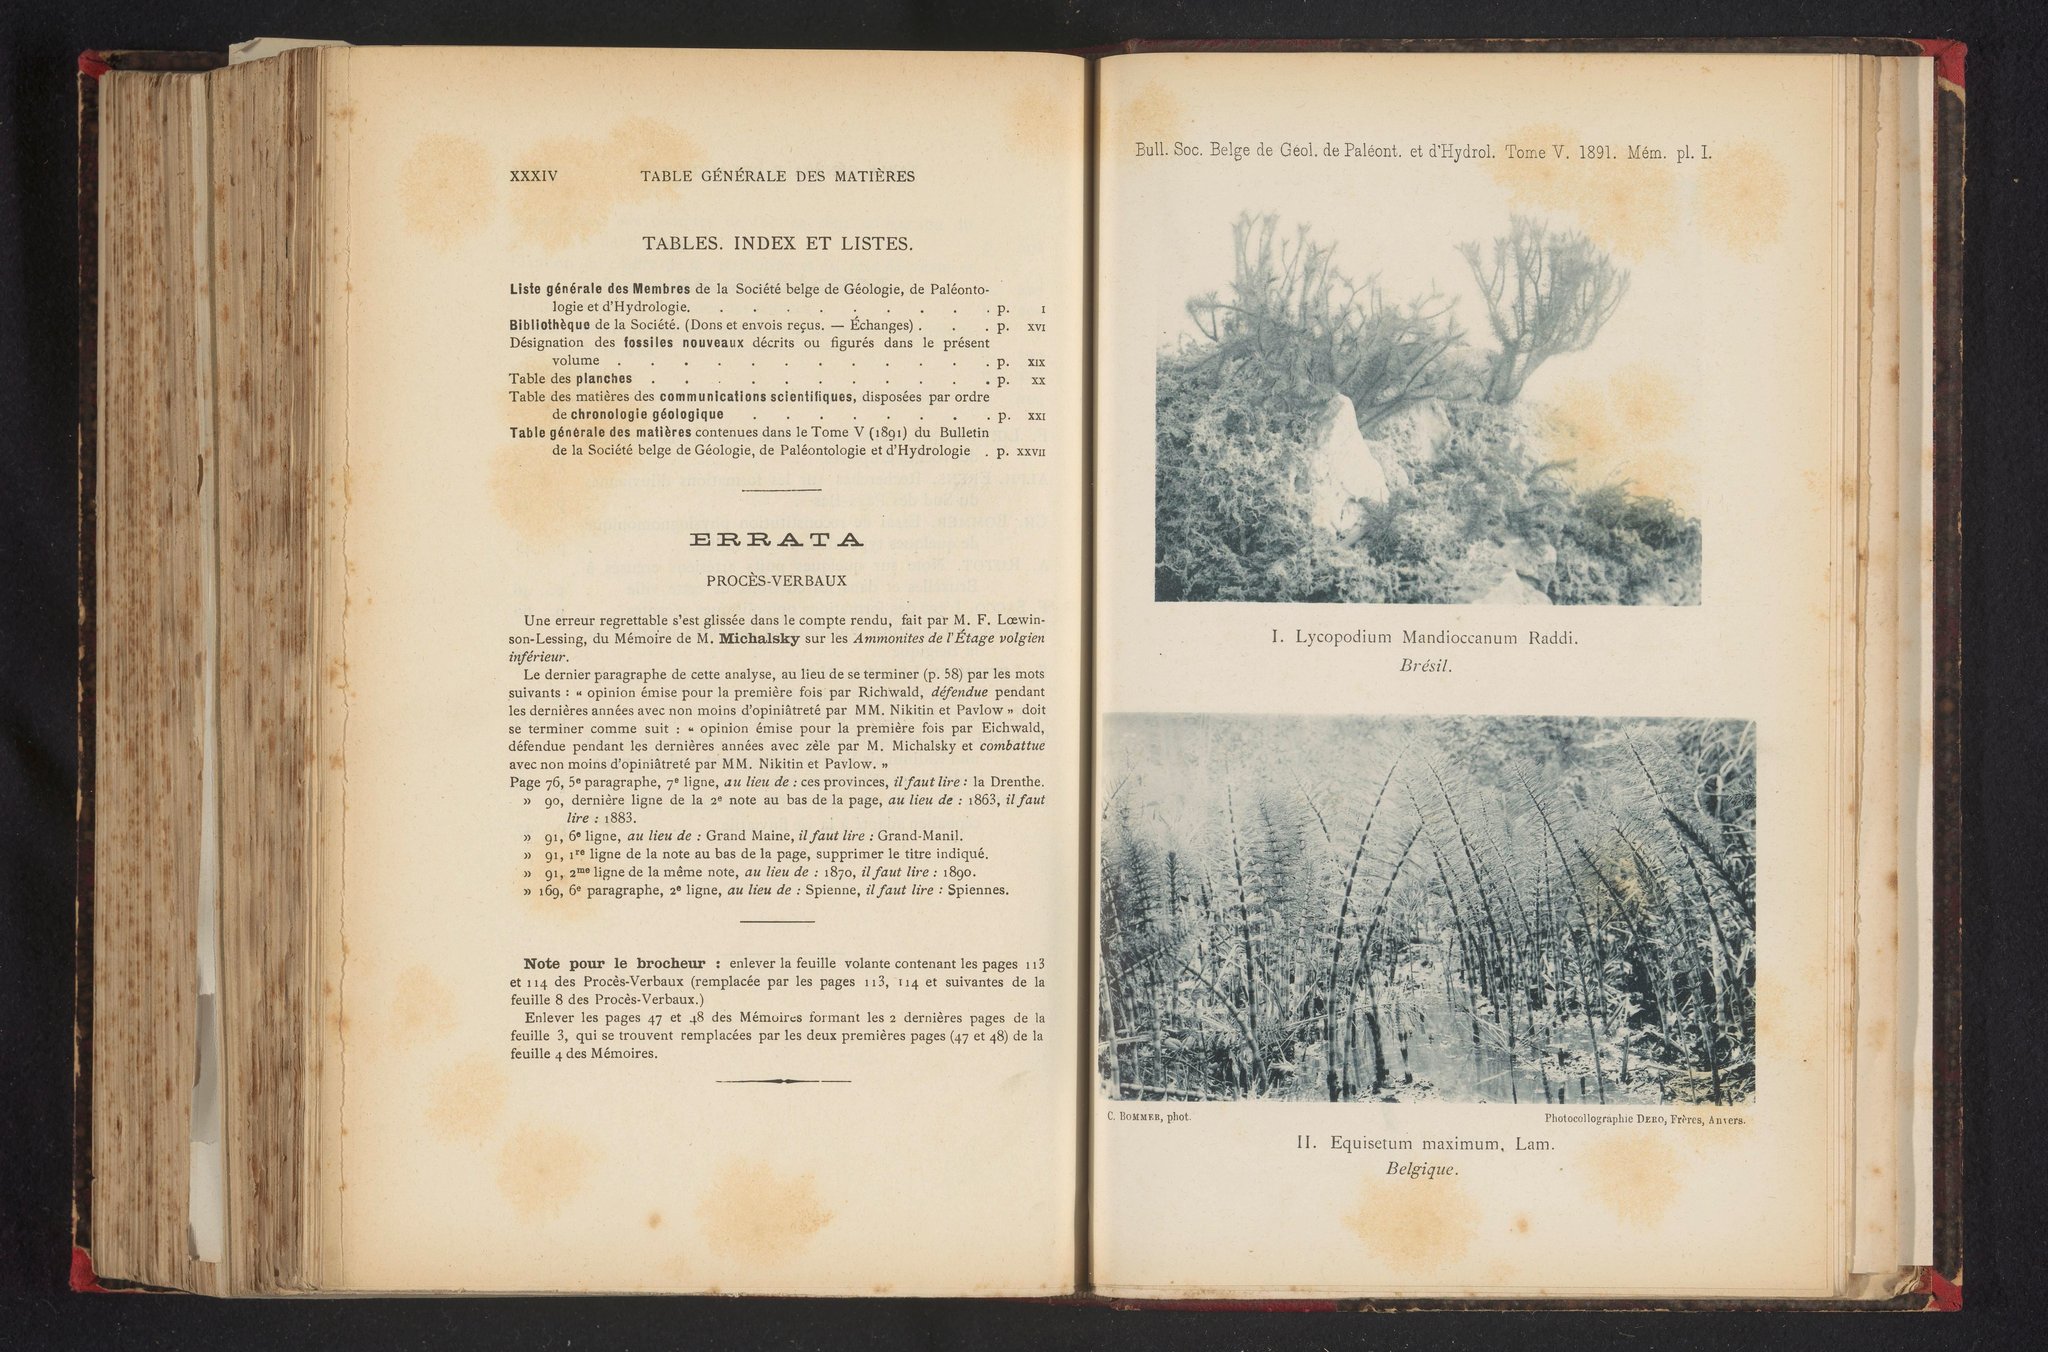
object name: page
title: Lycopodium Mandioccanum Raddi. Brésil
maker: Anonymous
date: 1885-1890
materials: paper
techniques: photograph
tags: plants; vegetation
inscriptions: inscription: ‘Bull. Soc. Belge de Géol. de Paléont. et d'Hydrol. Tome V. 1891. Mém. pl. I.’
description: Prent tegenover pagina XXXIV van deel 2.